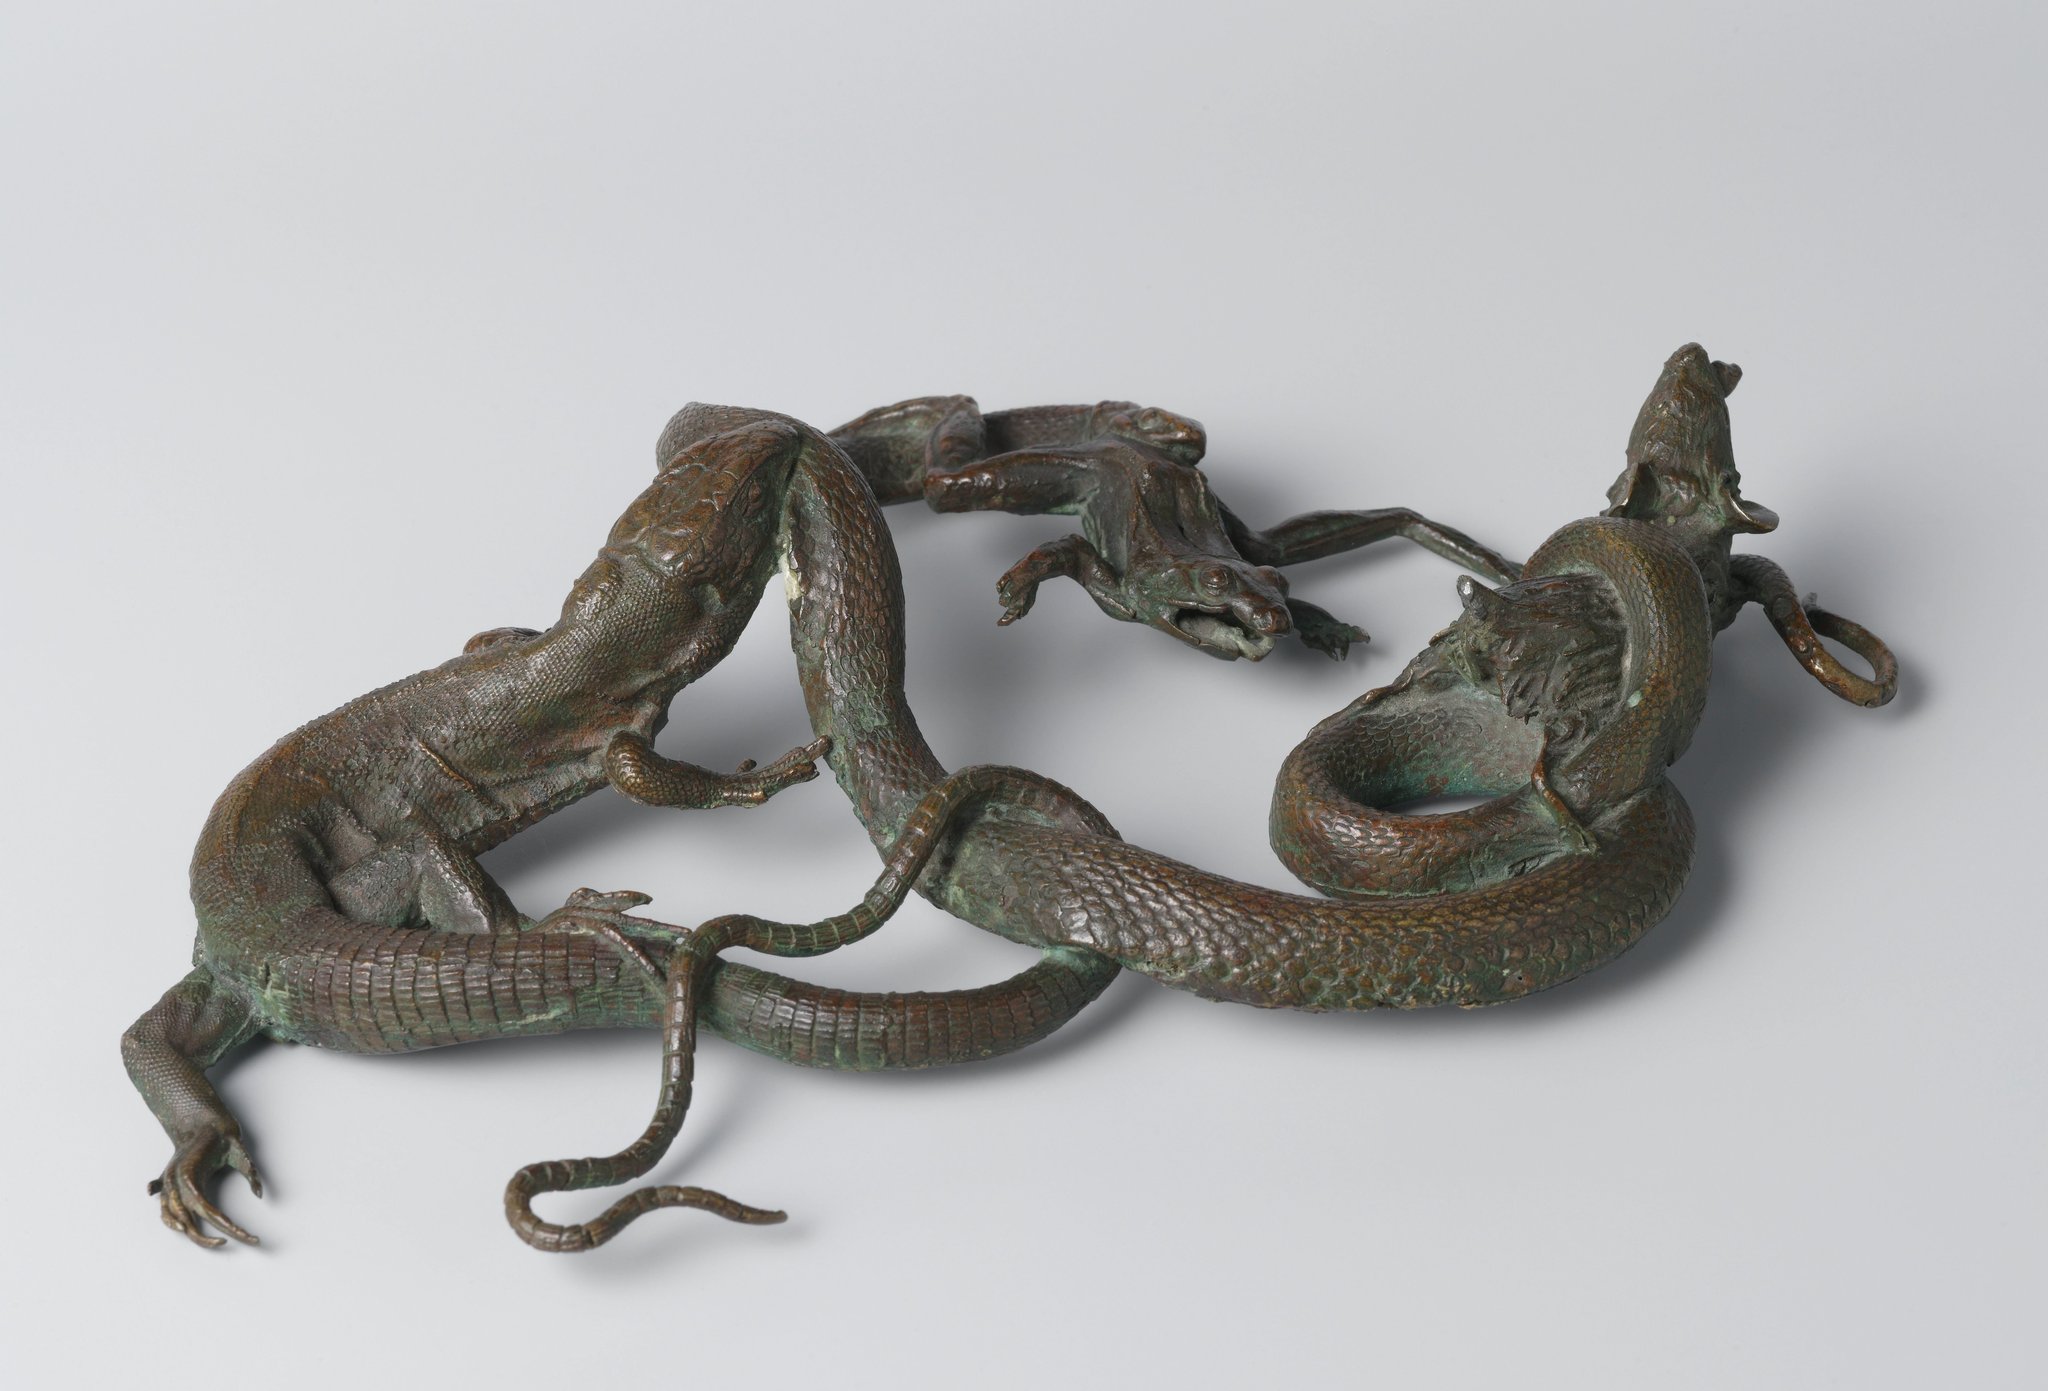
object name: sculpture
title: Snake, lizard, frog and mouse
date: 1550-1599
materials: bronze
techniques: lost wax process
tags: tailless amphibians: frog, snakes, rodents: mouse, lizards: lizard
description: Ever since the 14th century Italian sculptors made casts of real animals, shells and plants. They thus manifested themselves as creators who replicated the work of God or Mother Nature in other materials. This cast is unusual because it consists of four different creatures: an emerald lizard, a dice snake, a frog and a mouse.